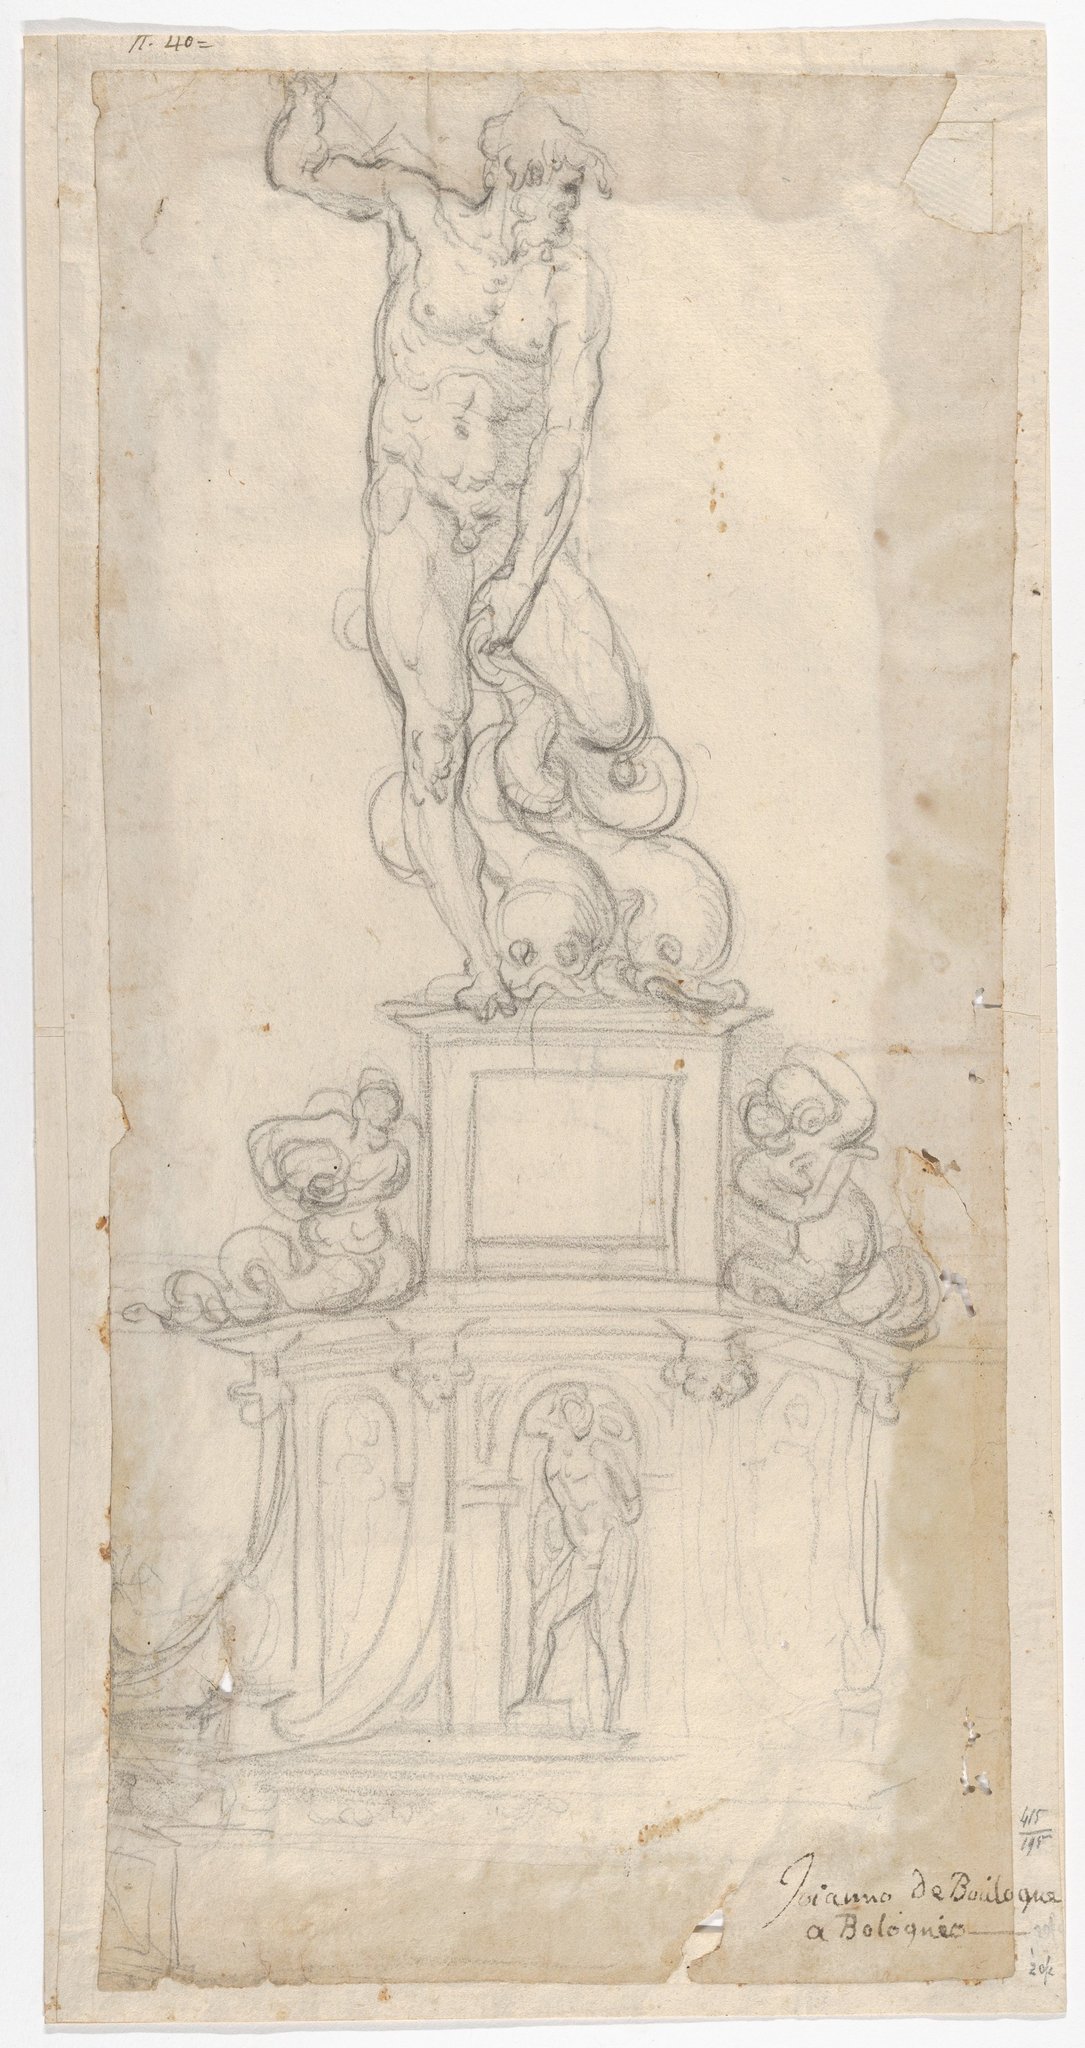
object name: drawing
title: Study for a Sculpture of Neptune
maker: giambologna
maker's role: artist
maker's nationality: netherlandish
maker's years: 1529-1608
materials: chalk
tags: sculpture,neptune